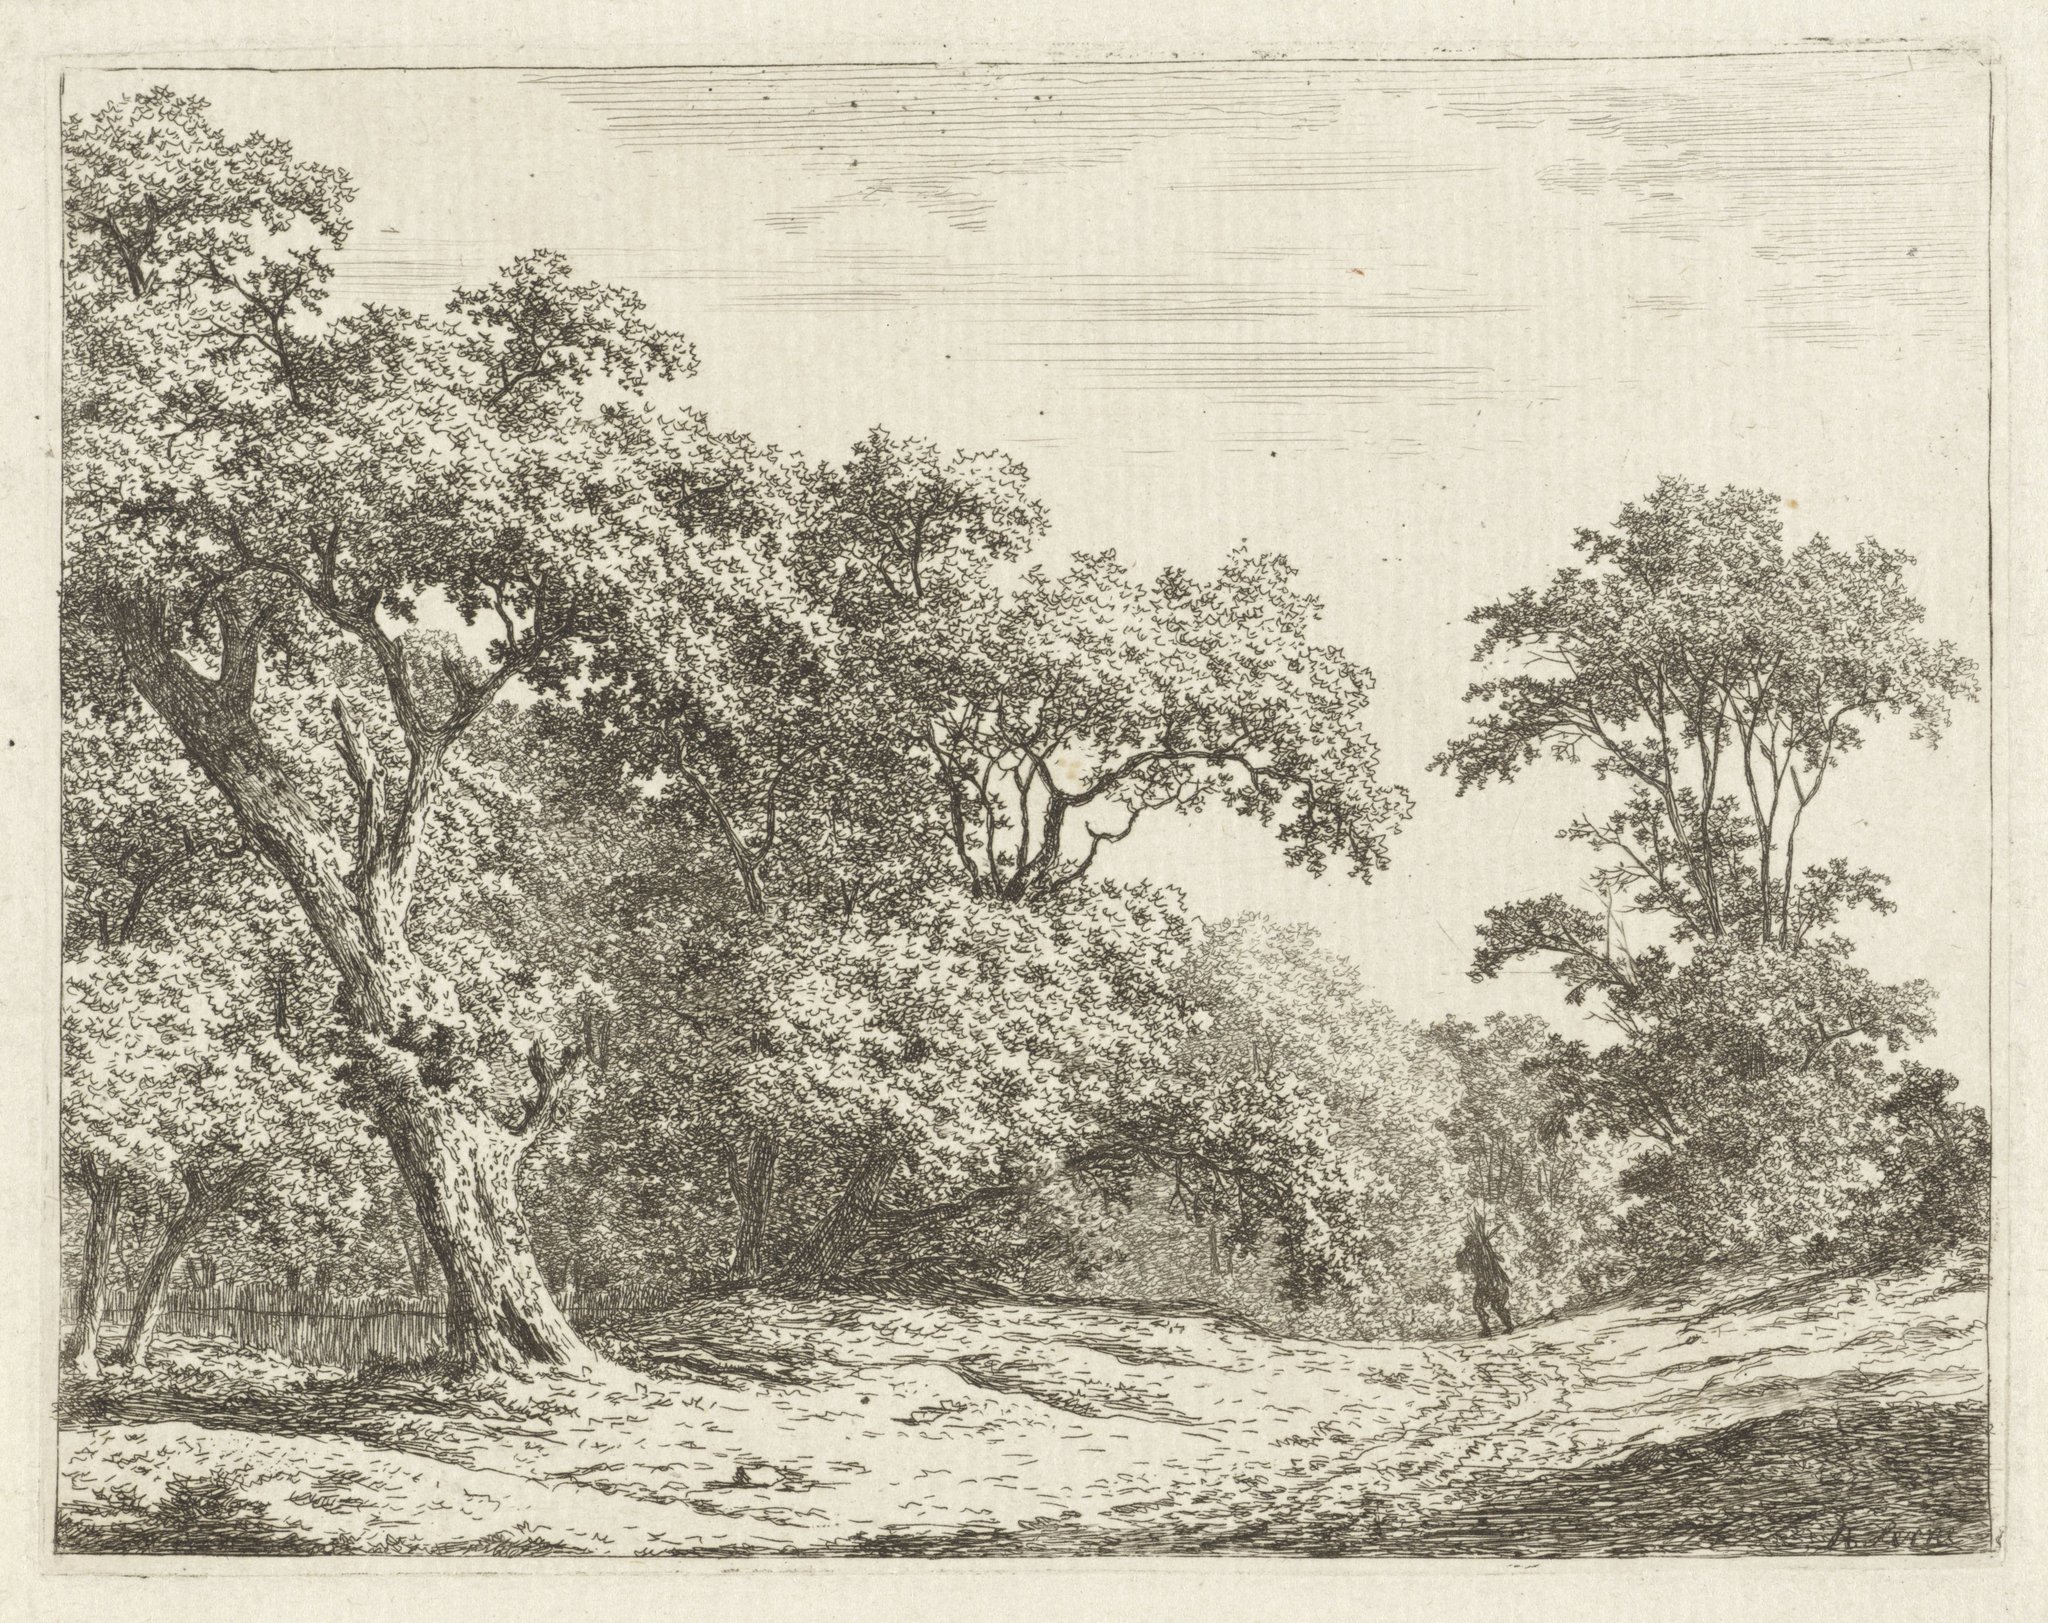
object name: print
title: Landschap met bomen en een man op weg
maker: adrianus serné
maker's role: print maker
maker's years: 1773-1853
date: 1783-1853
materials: paper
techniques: etching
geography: netherlands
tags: road, path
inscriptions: collector's mark: Lugt 2228